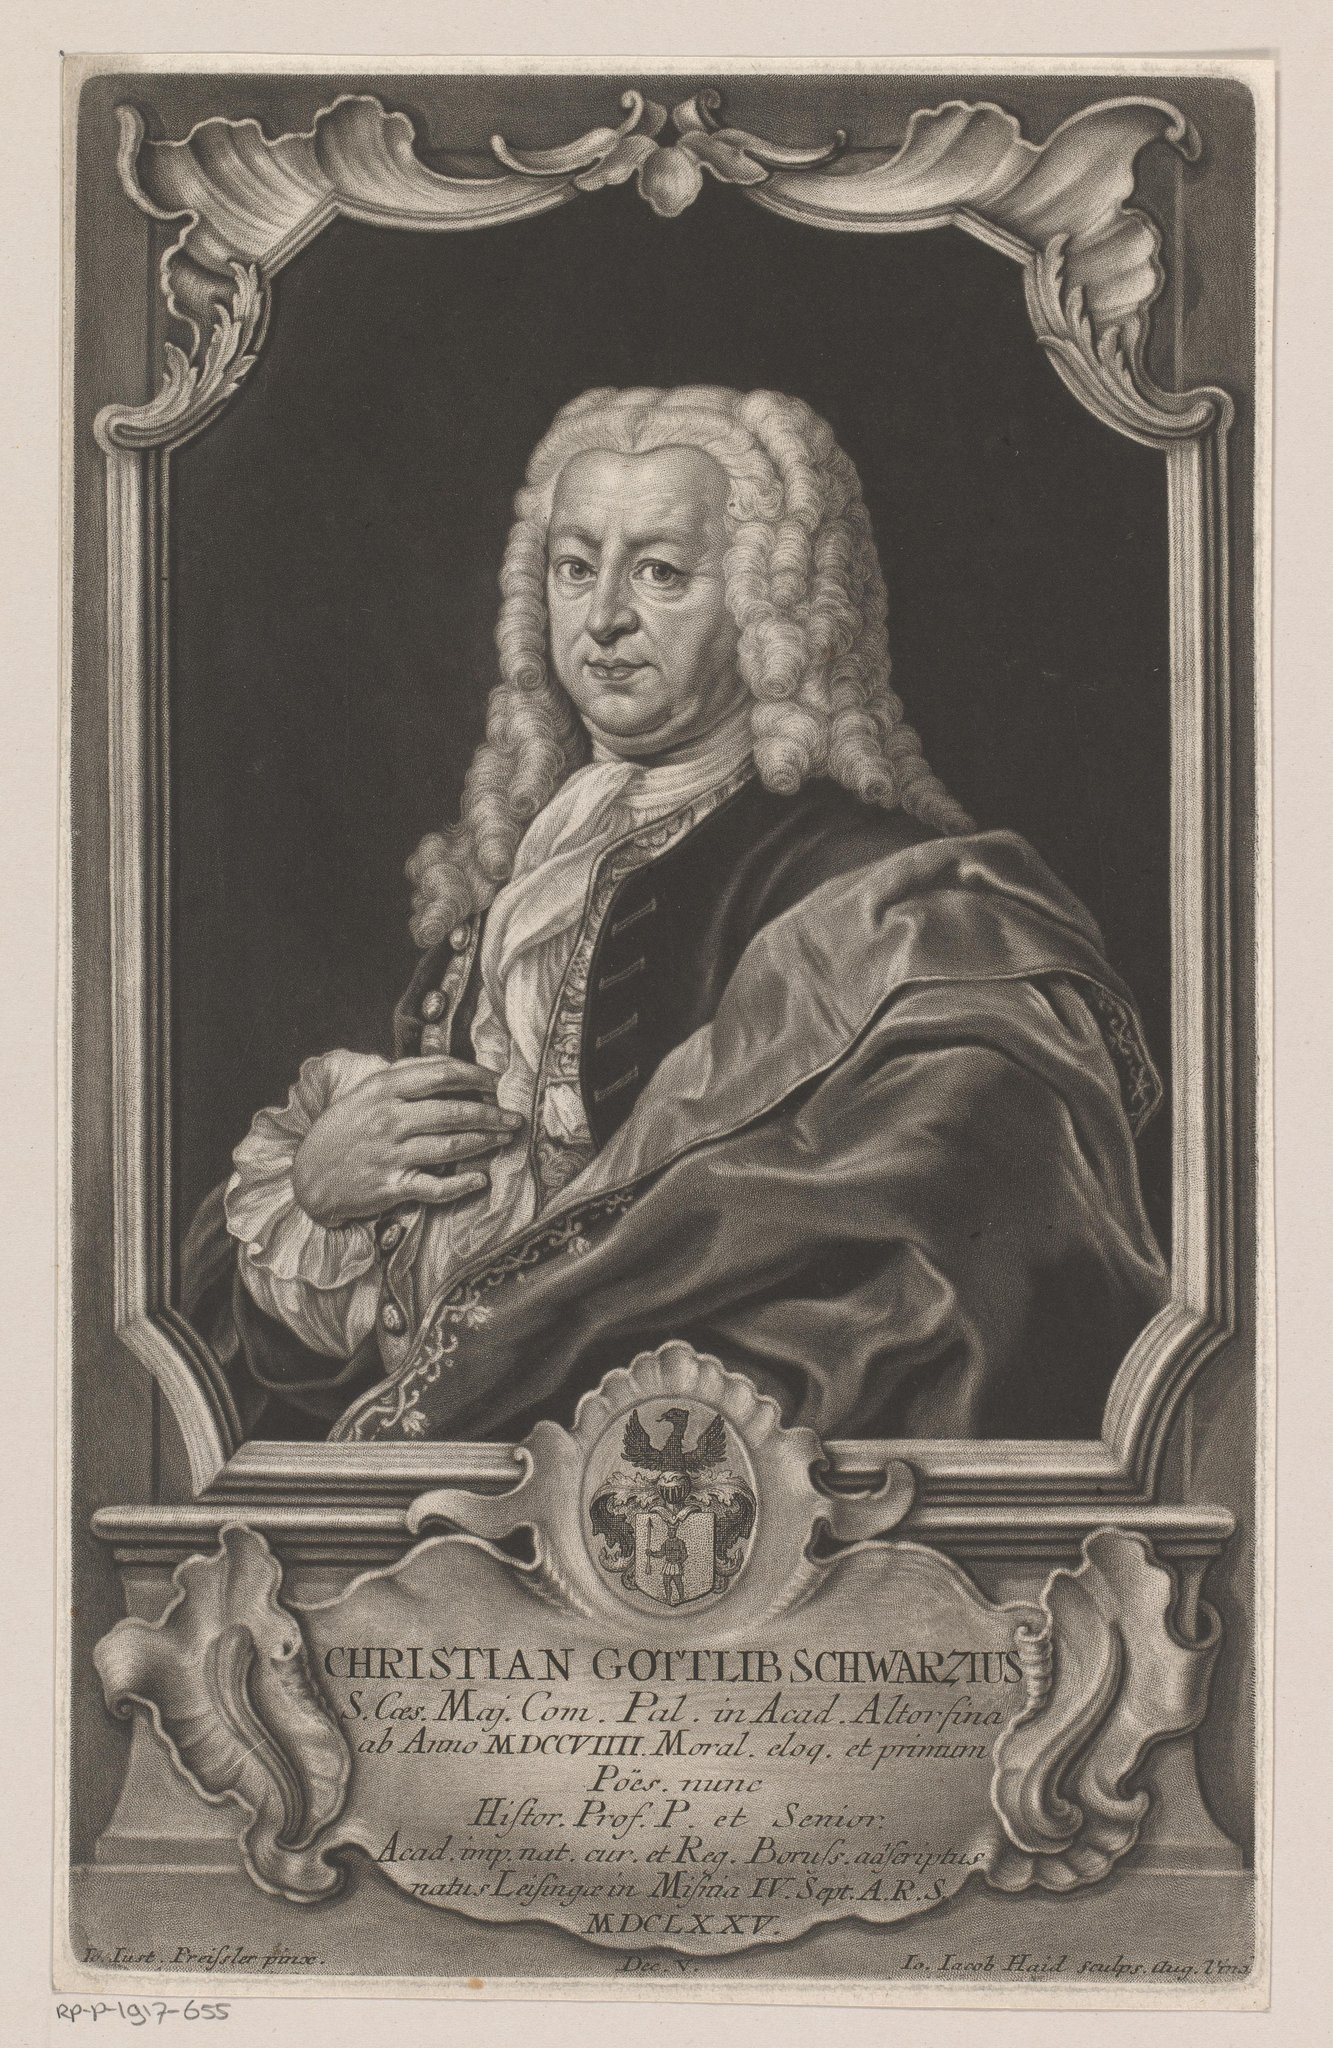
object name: print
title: Portret van Christian Gottlieb Schwarz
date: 1746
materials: paper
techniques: etching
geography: augsburg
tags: historical persons, portrait of a writer, historical disciplines; philology (+ portrait of scholar, scientist), professor, armorial bearing, heraldry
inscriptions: collector's mark: Lugt 2228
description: Prent mogelijk uit: Brucker, Jacob. Bildersal heutiges Tages lebender und durch Gelahrheit berühmter Schrifftsteller. Augsburg: Johann Jacob Haid, 1746.